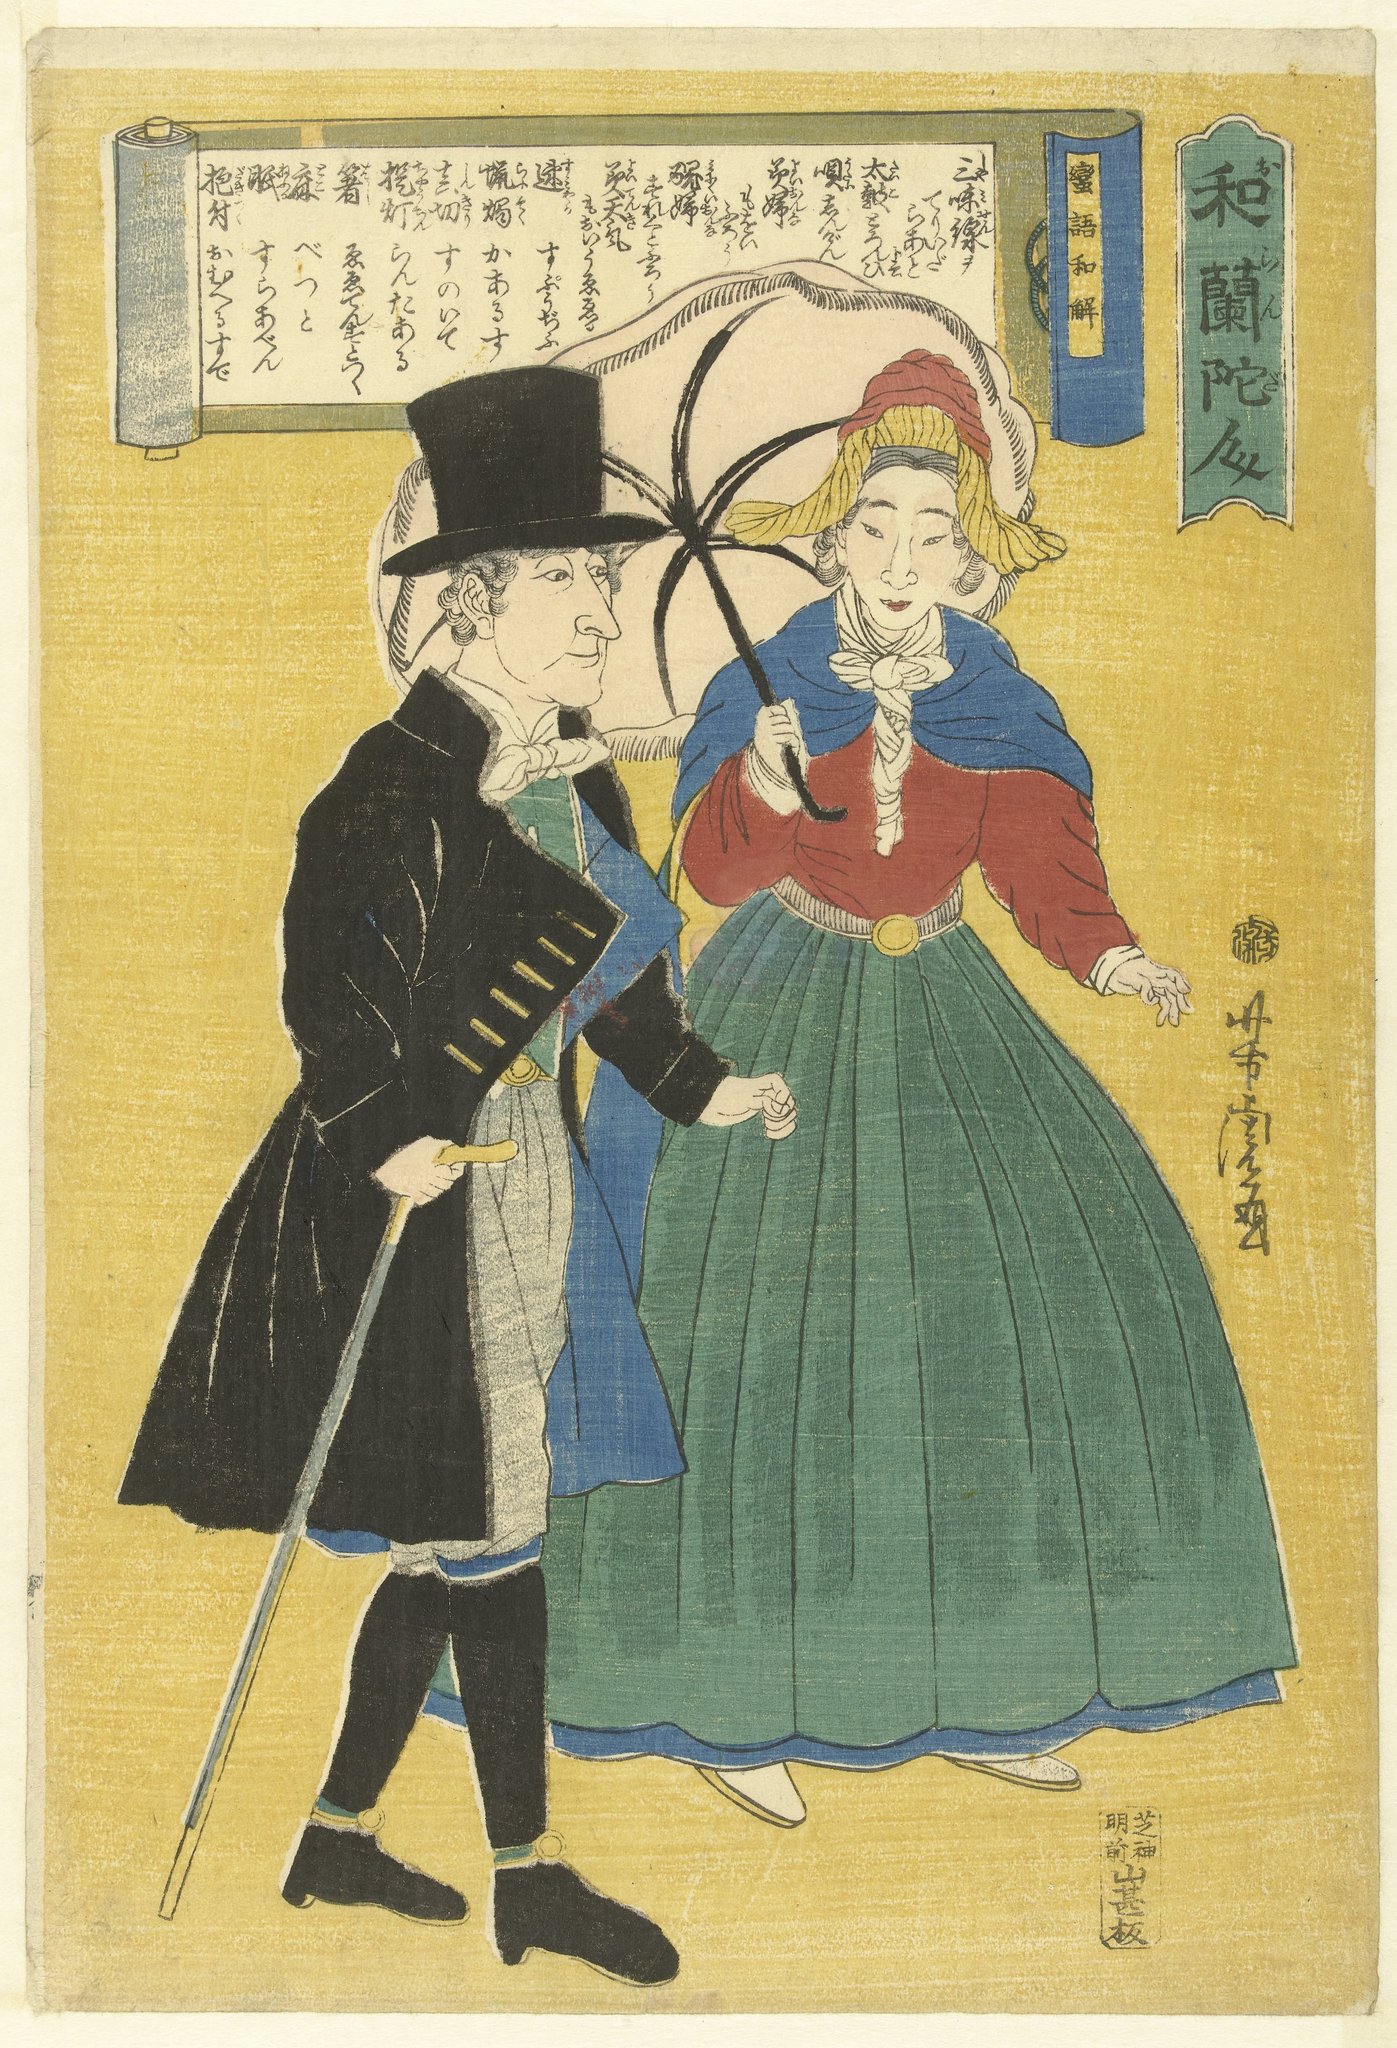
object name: print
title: Orandajin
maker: utagawa yoshitora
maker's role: print maker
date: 1862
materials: paper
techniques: woodcut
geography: japan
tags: human types; peoples and nationalities, walking-stick, staff, folk costume, regional costume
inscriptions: collector's mark: Lugt 2228